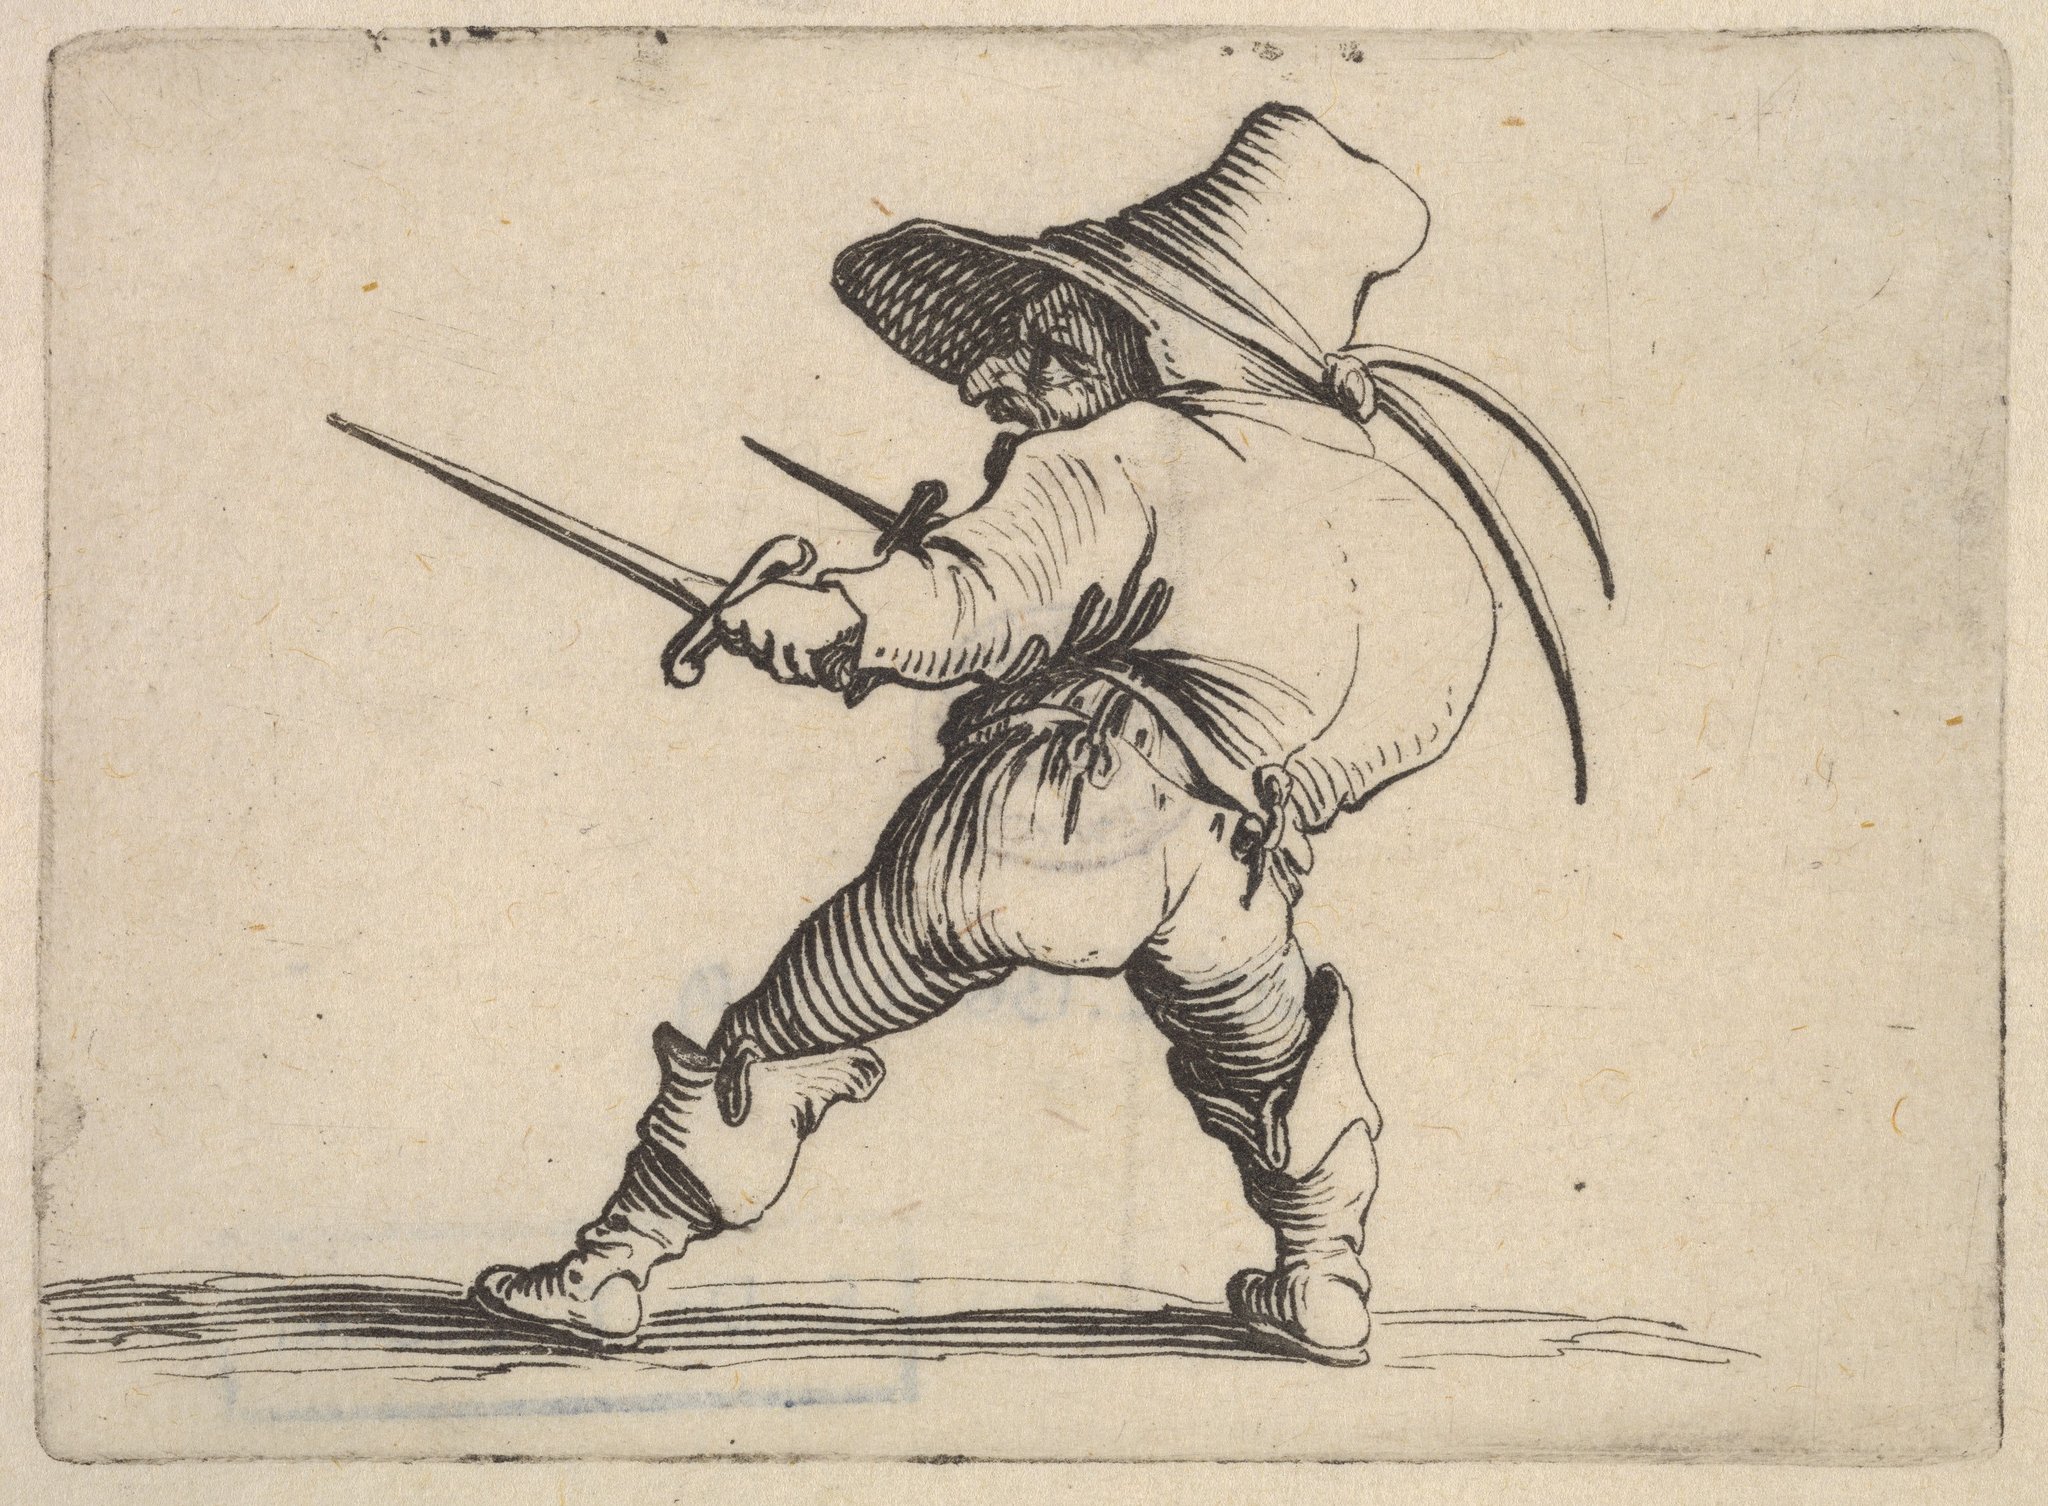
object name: print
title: Small male figure wearing a hat, with daggers in both hands, and placing his weight on his right foot as he stretches his left foot forward, from "Varie Figure Gobbi"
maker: jacques callot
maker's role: artist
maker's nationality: french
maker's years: 1592-1635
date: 1621-1625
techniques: etching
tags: hats,daggers,men